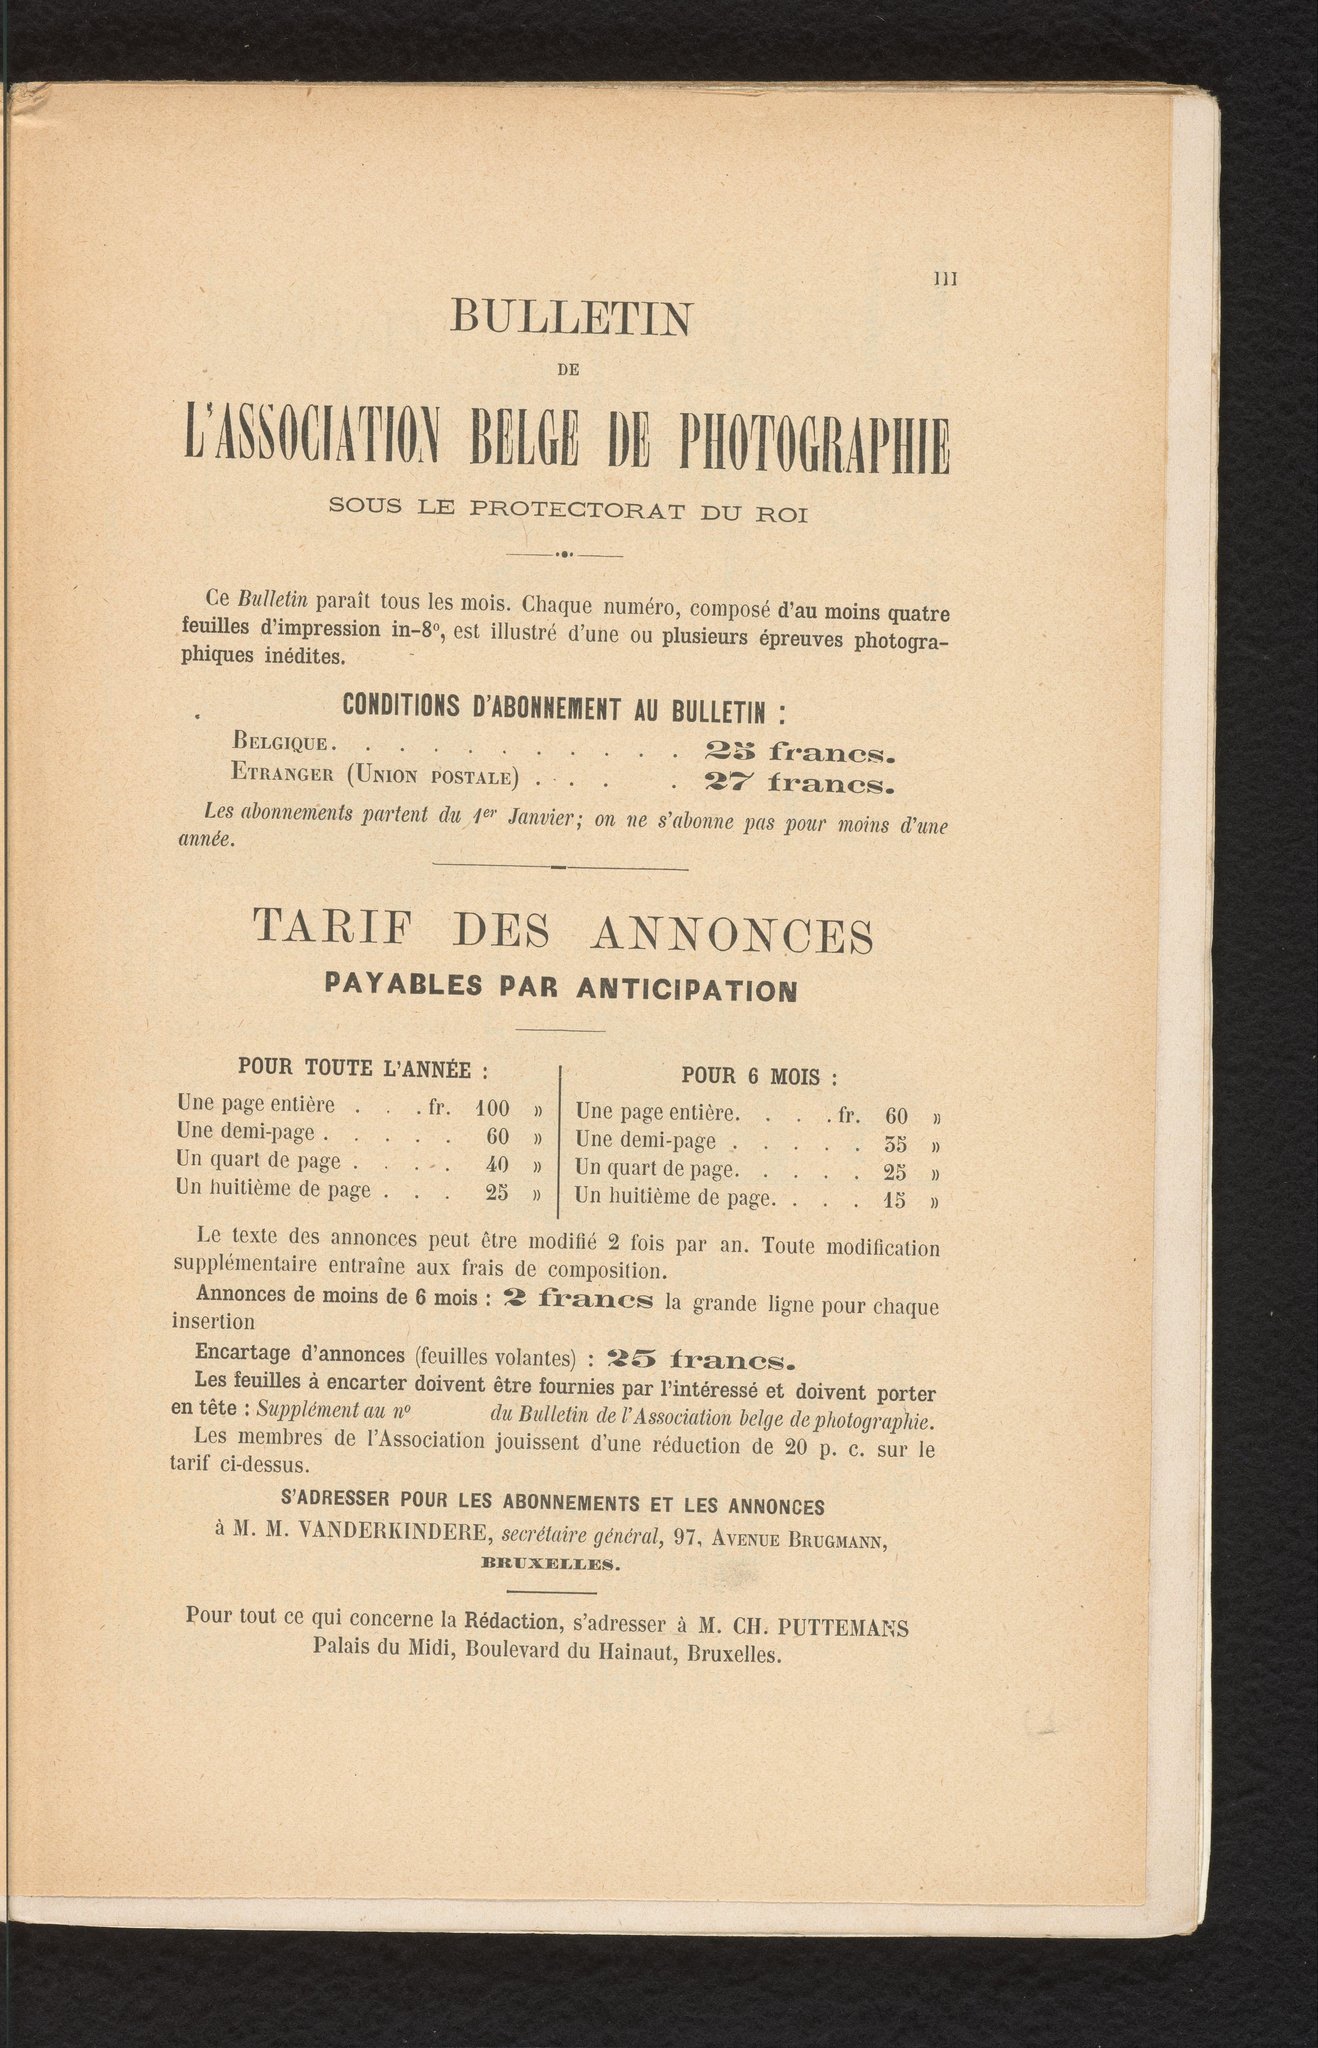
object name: book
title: Bulletin / Association belge de photographie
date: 1807-1899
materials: paper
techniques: printing, engraving